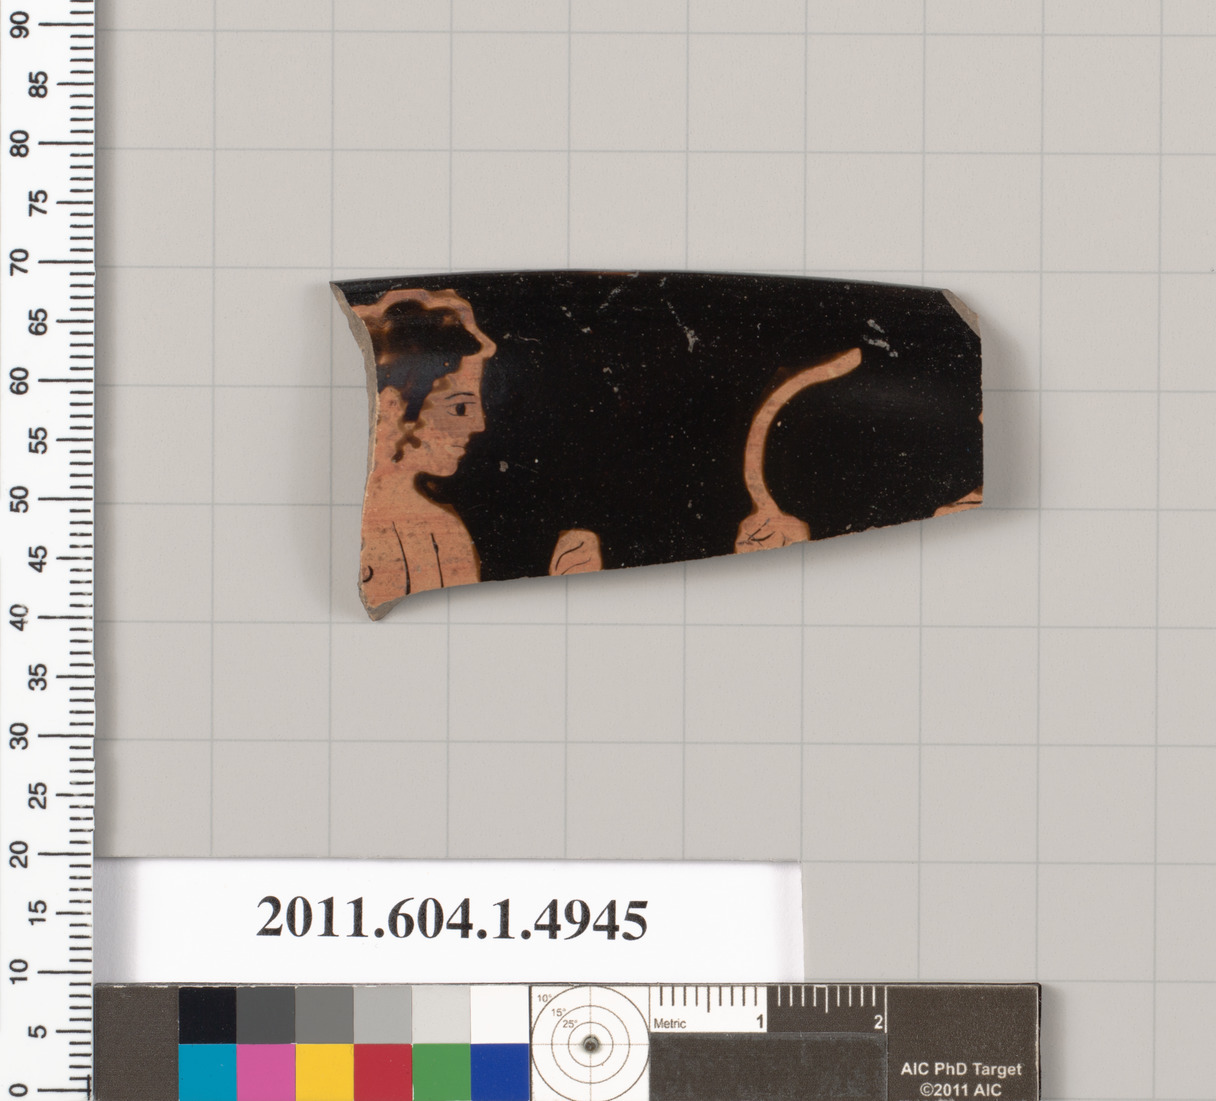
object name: kylix fragment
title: Terracotta rim fragment of a kylix (drinking cup)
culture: greek, attic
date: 467-435 BCE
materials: terracotta